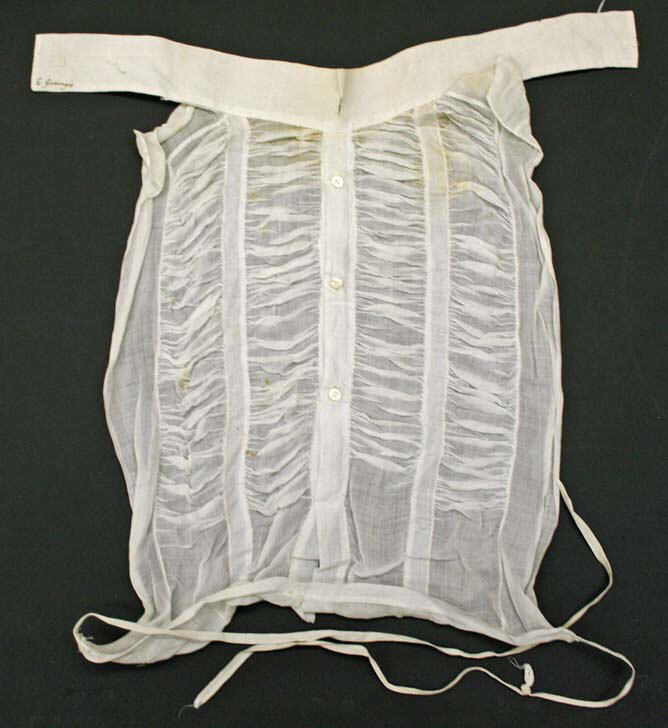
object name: dickey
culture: american or european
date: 1830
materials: linen